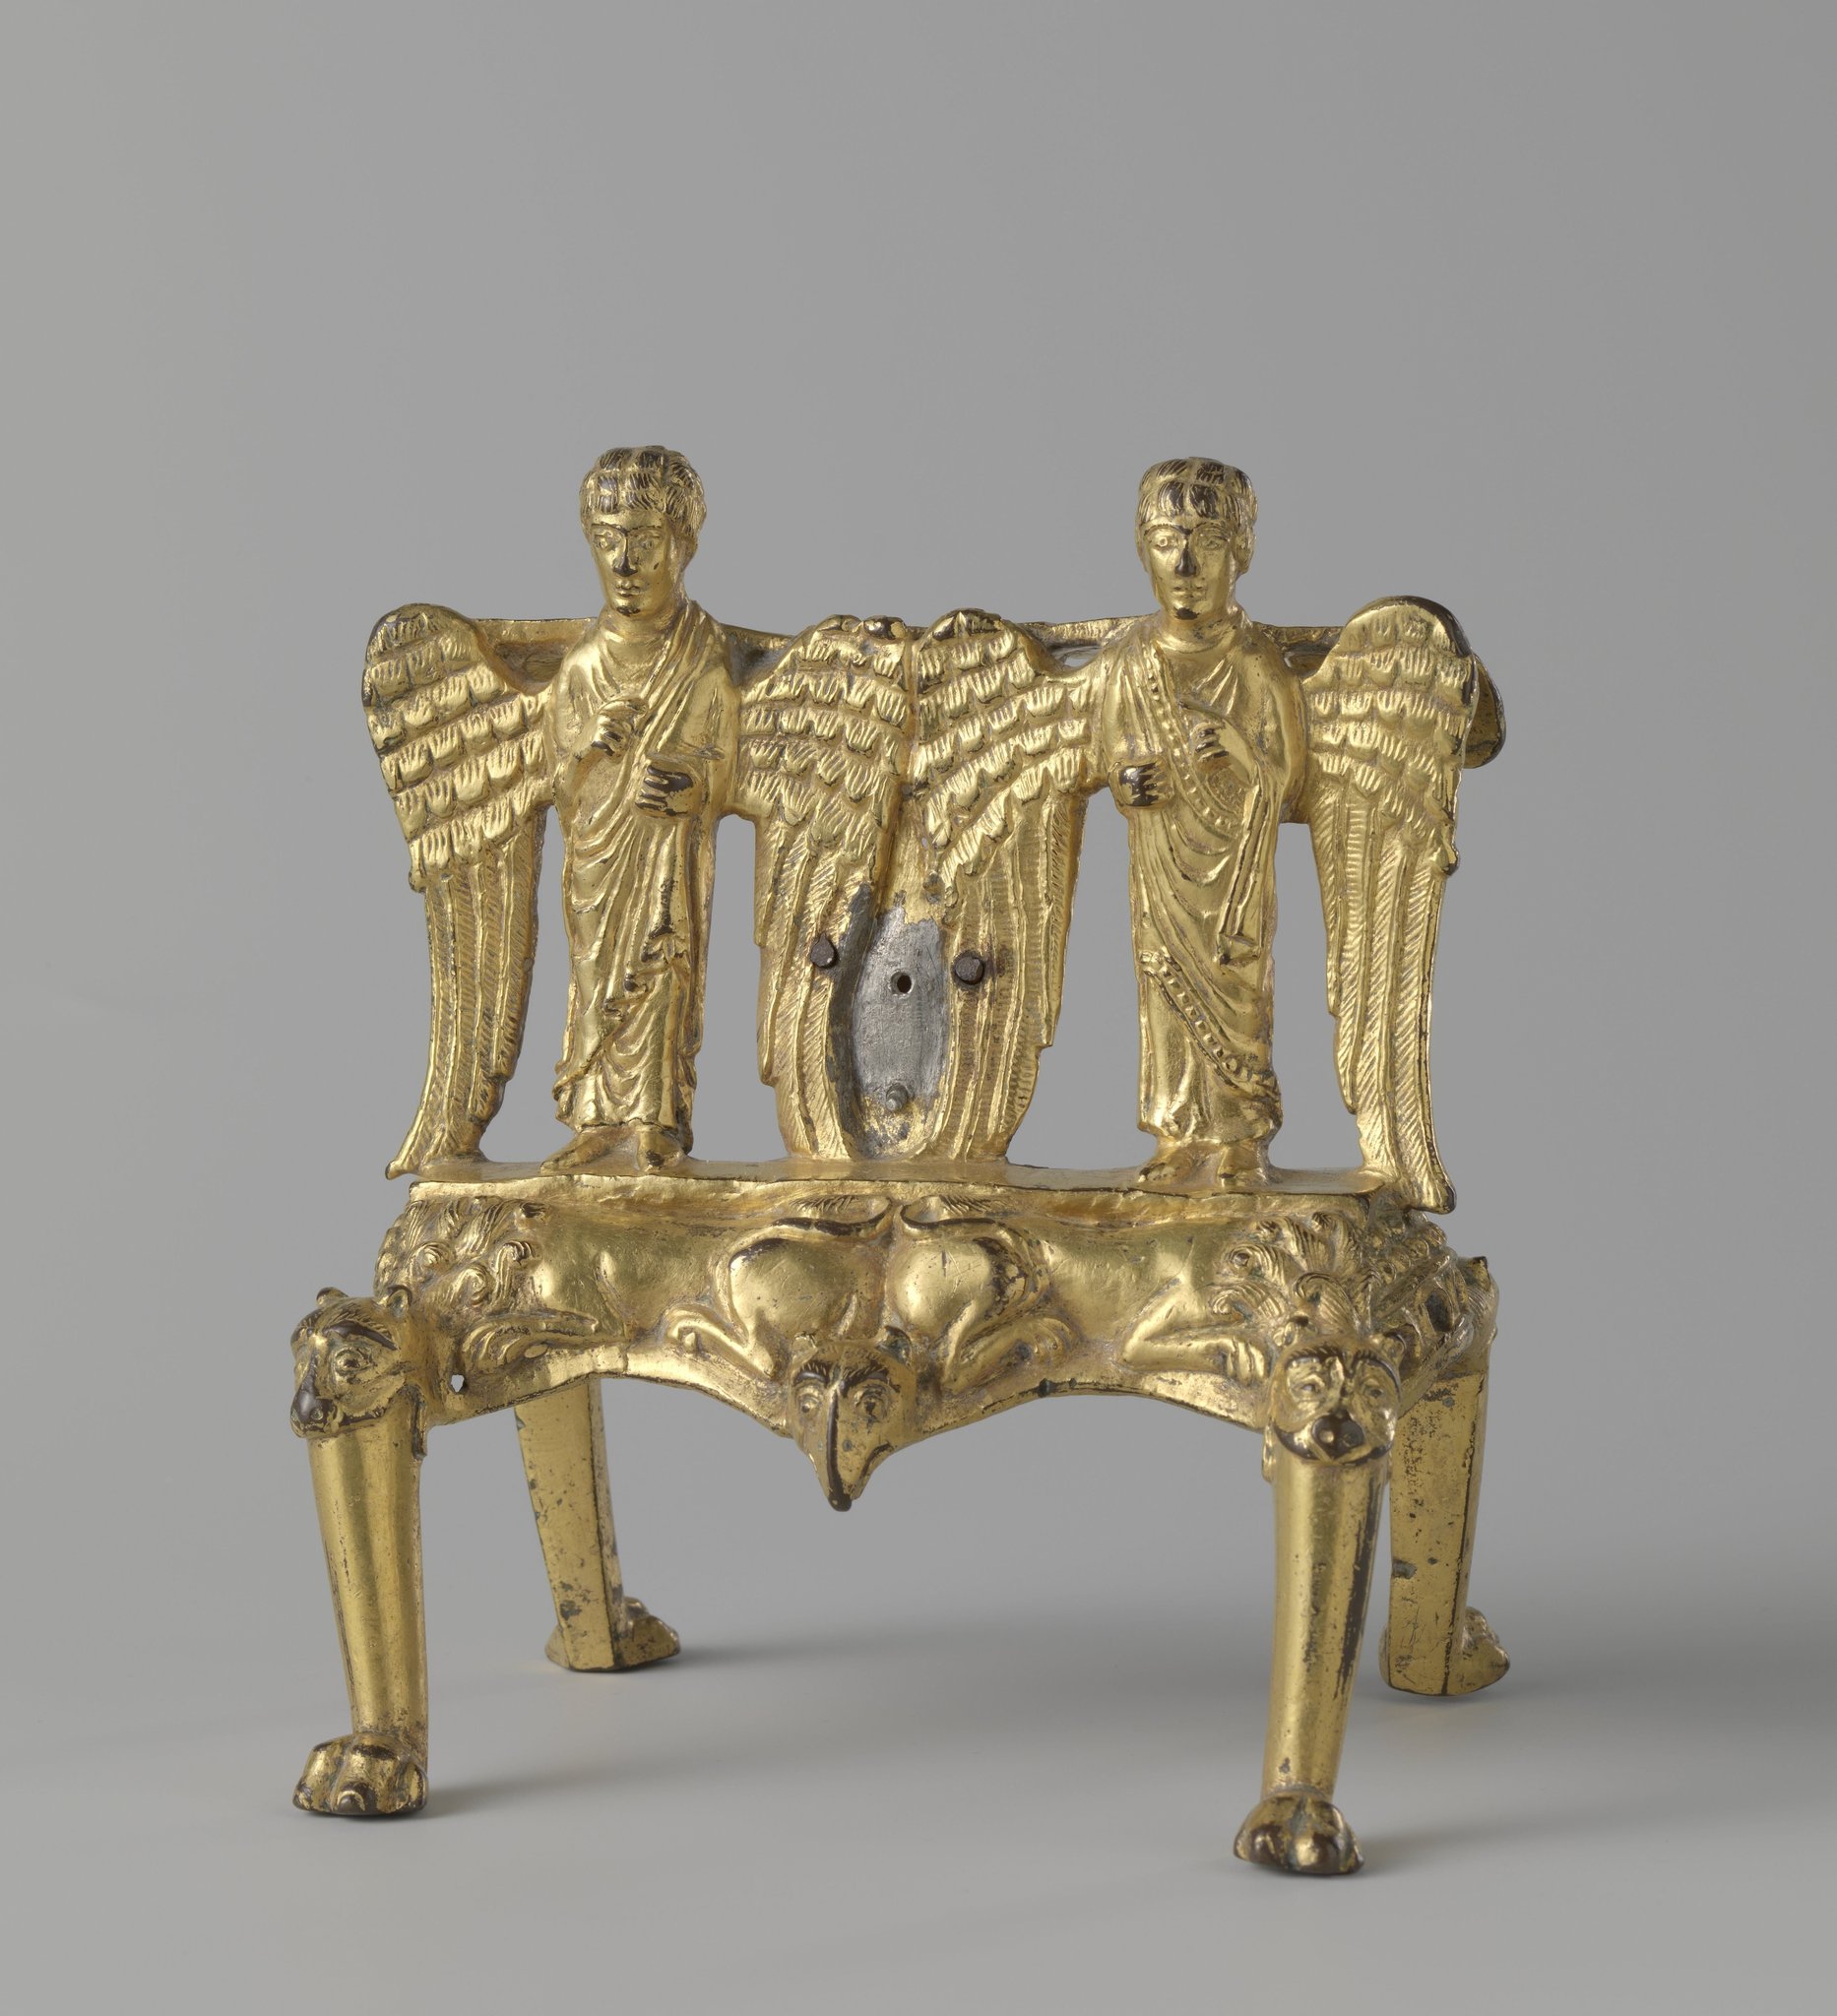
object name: stand support object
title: Stand for an altar cross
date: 1170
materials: bronze, iron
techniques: casting, metalworking, woodworking, engraving, gilding, riveted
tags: ornament ~ hybrid animals, angels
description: Het voorwerp is in meerdere delen gegoten. Vervolgens is het geciseleerd, hier en daar gegraveerd en in zijn geheel verguld (ook de onderkant). Twee engelen staan naast elkaar op een rechthoekige grond, die rust op een voetstuk, aan voor- en achterkant bestaand uit telkens twee liggende leeuwen, de koppen op de hoeken en in het midden de kop van een basilisk. Uit de opengesperde muilen komen de klauwpoten voort. De zijkanten bollen iets uit en hebben een in twee rijen aangebrachte versiering, bestaande uit het motief van een bol-met-gaatje, boven een arcaderand met vijf of zes openingen. De engelen staan naast elkaar en hebben hun vleugels gespreid. Proportioneel gezien zijn vleugels en hoofden te groot voor de lichamen. De engelen wijzen met hun rechter- of linkerhand omhoog. Haardracht, tunica's en vleugels zijn gedetailleerd aangegeven. Aan de achterkant van deze figuren bevindt zich tegen de vleugels en schouders een horizontaal verbindingsstuk met een vierkant gat in het midden en ronde einden aan weerszijden. Ook in het voetstuk, waarop de engelen staan, is aan de achterkant een vierkant gat gemaakt, zodat door beide openingen de voet van het ontbrekende kruis kan worden geplaatst. Tussen de vleugels is in het midden aan de achterkant een ronde ijzeren ring geklonken, die dient als steun van de voet van het kruis, en is aldaar tevens een gaatje geboord. Dit is ook gebeurd aan weerszijden van het vierkante gat in het voetstuk. De poten van het voetstuk en de ronde einden van het verstevigingsstuk zijn iets verbogen.